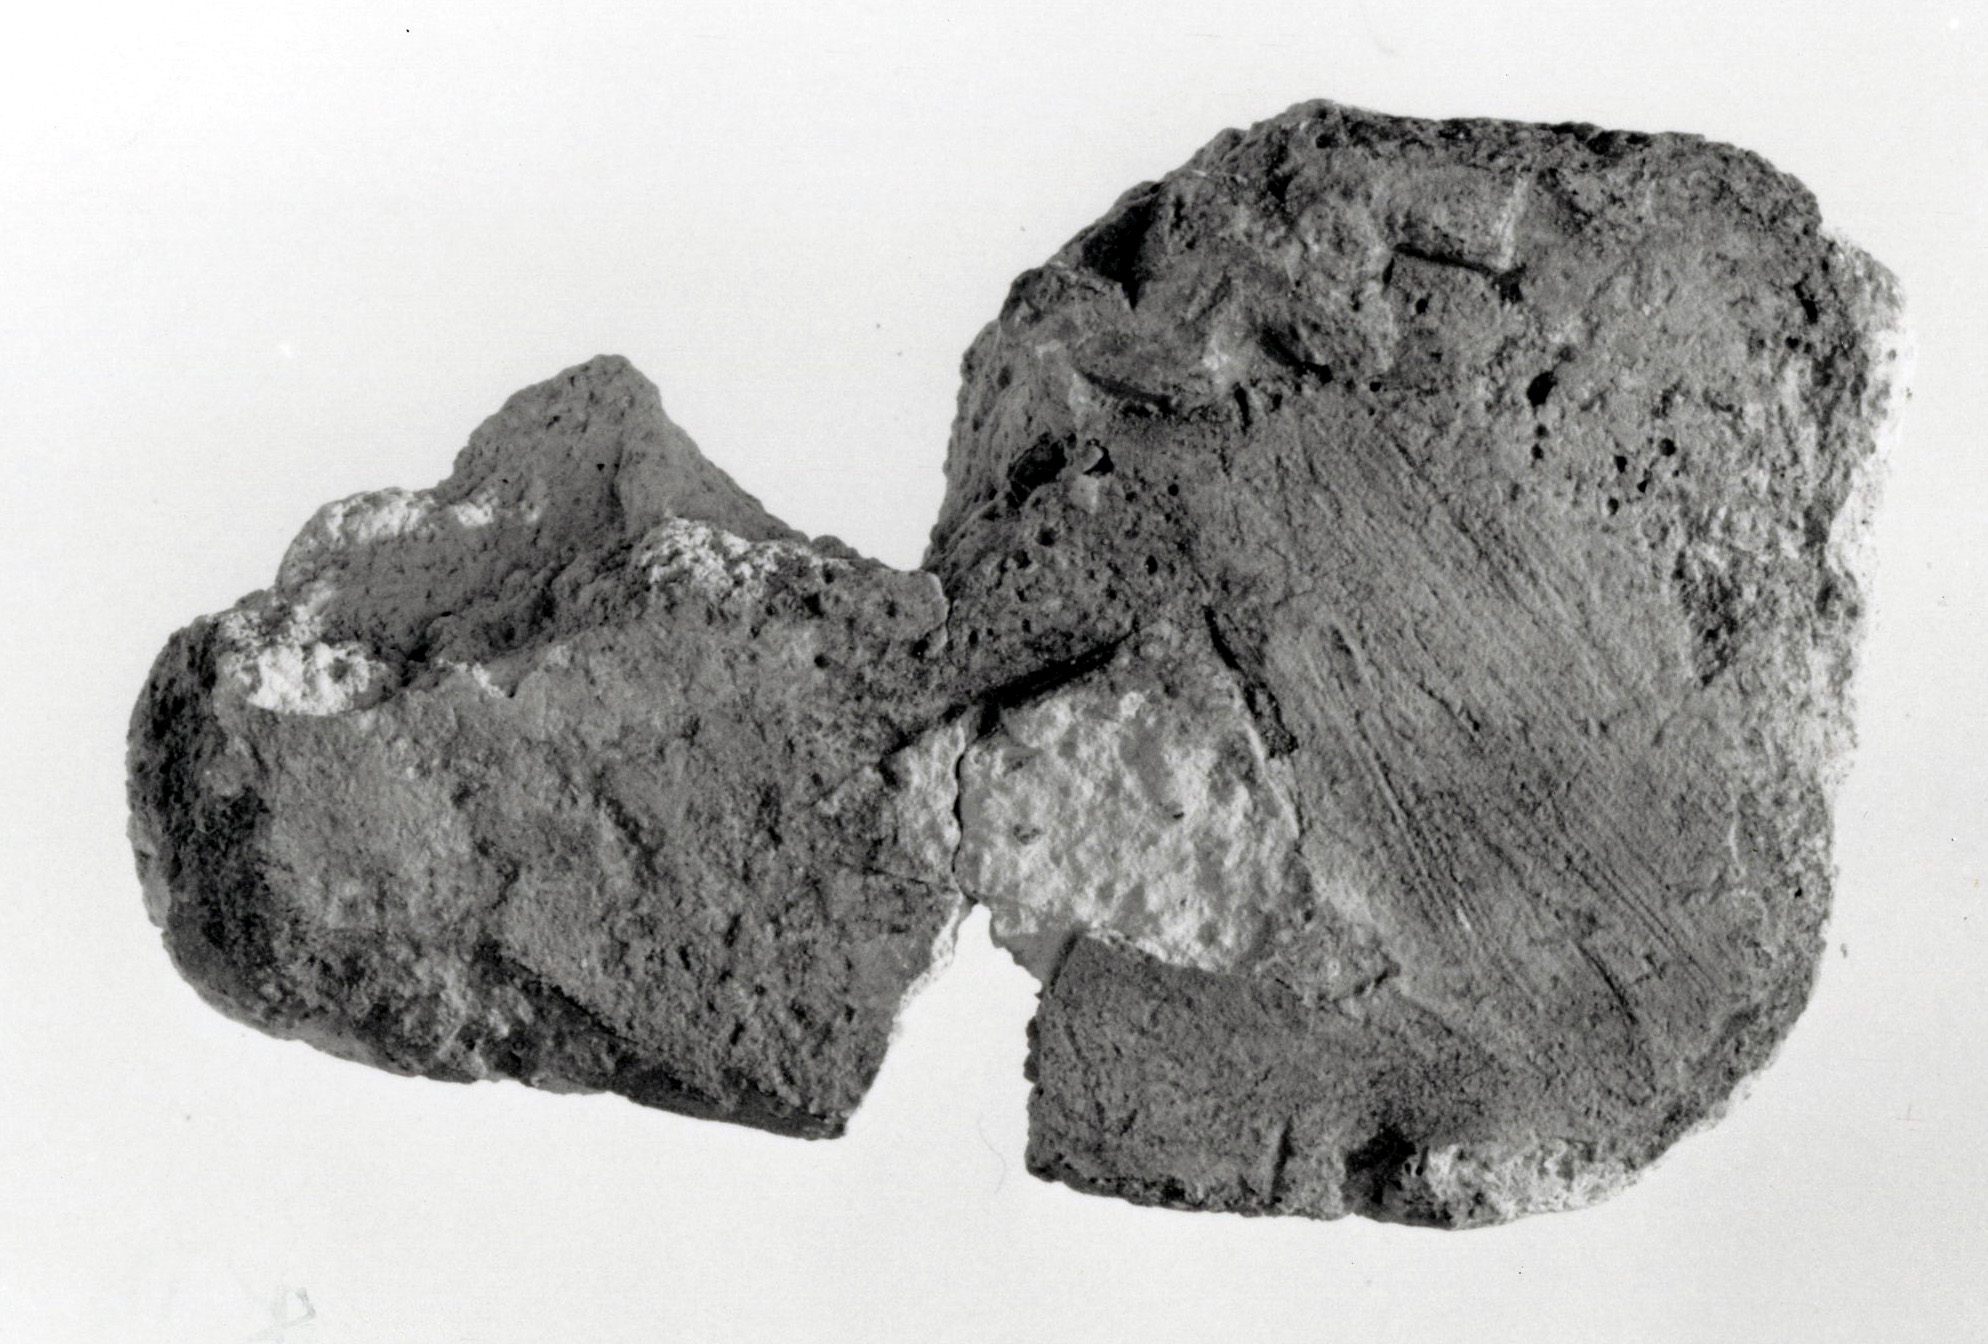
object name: relief, tomb of nespekashuty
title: Raised relief fragment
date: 664-610 BCE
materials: gypsum, mortar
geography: egypt